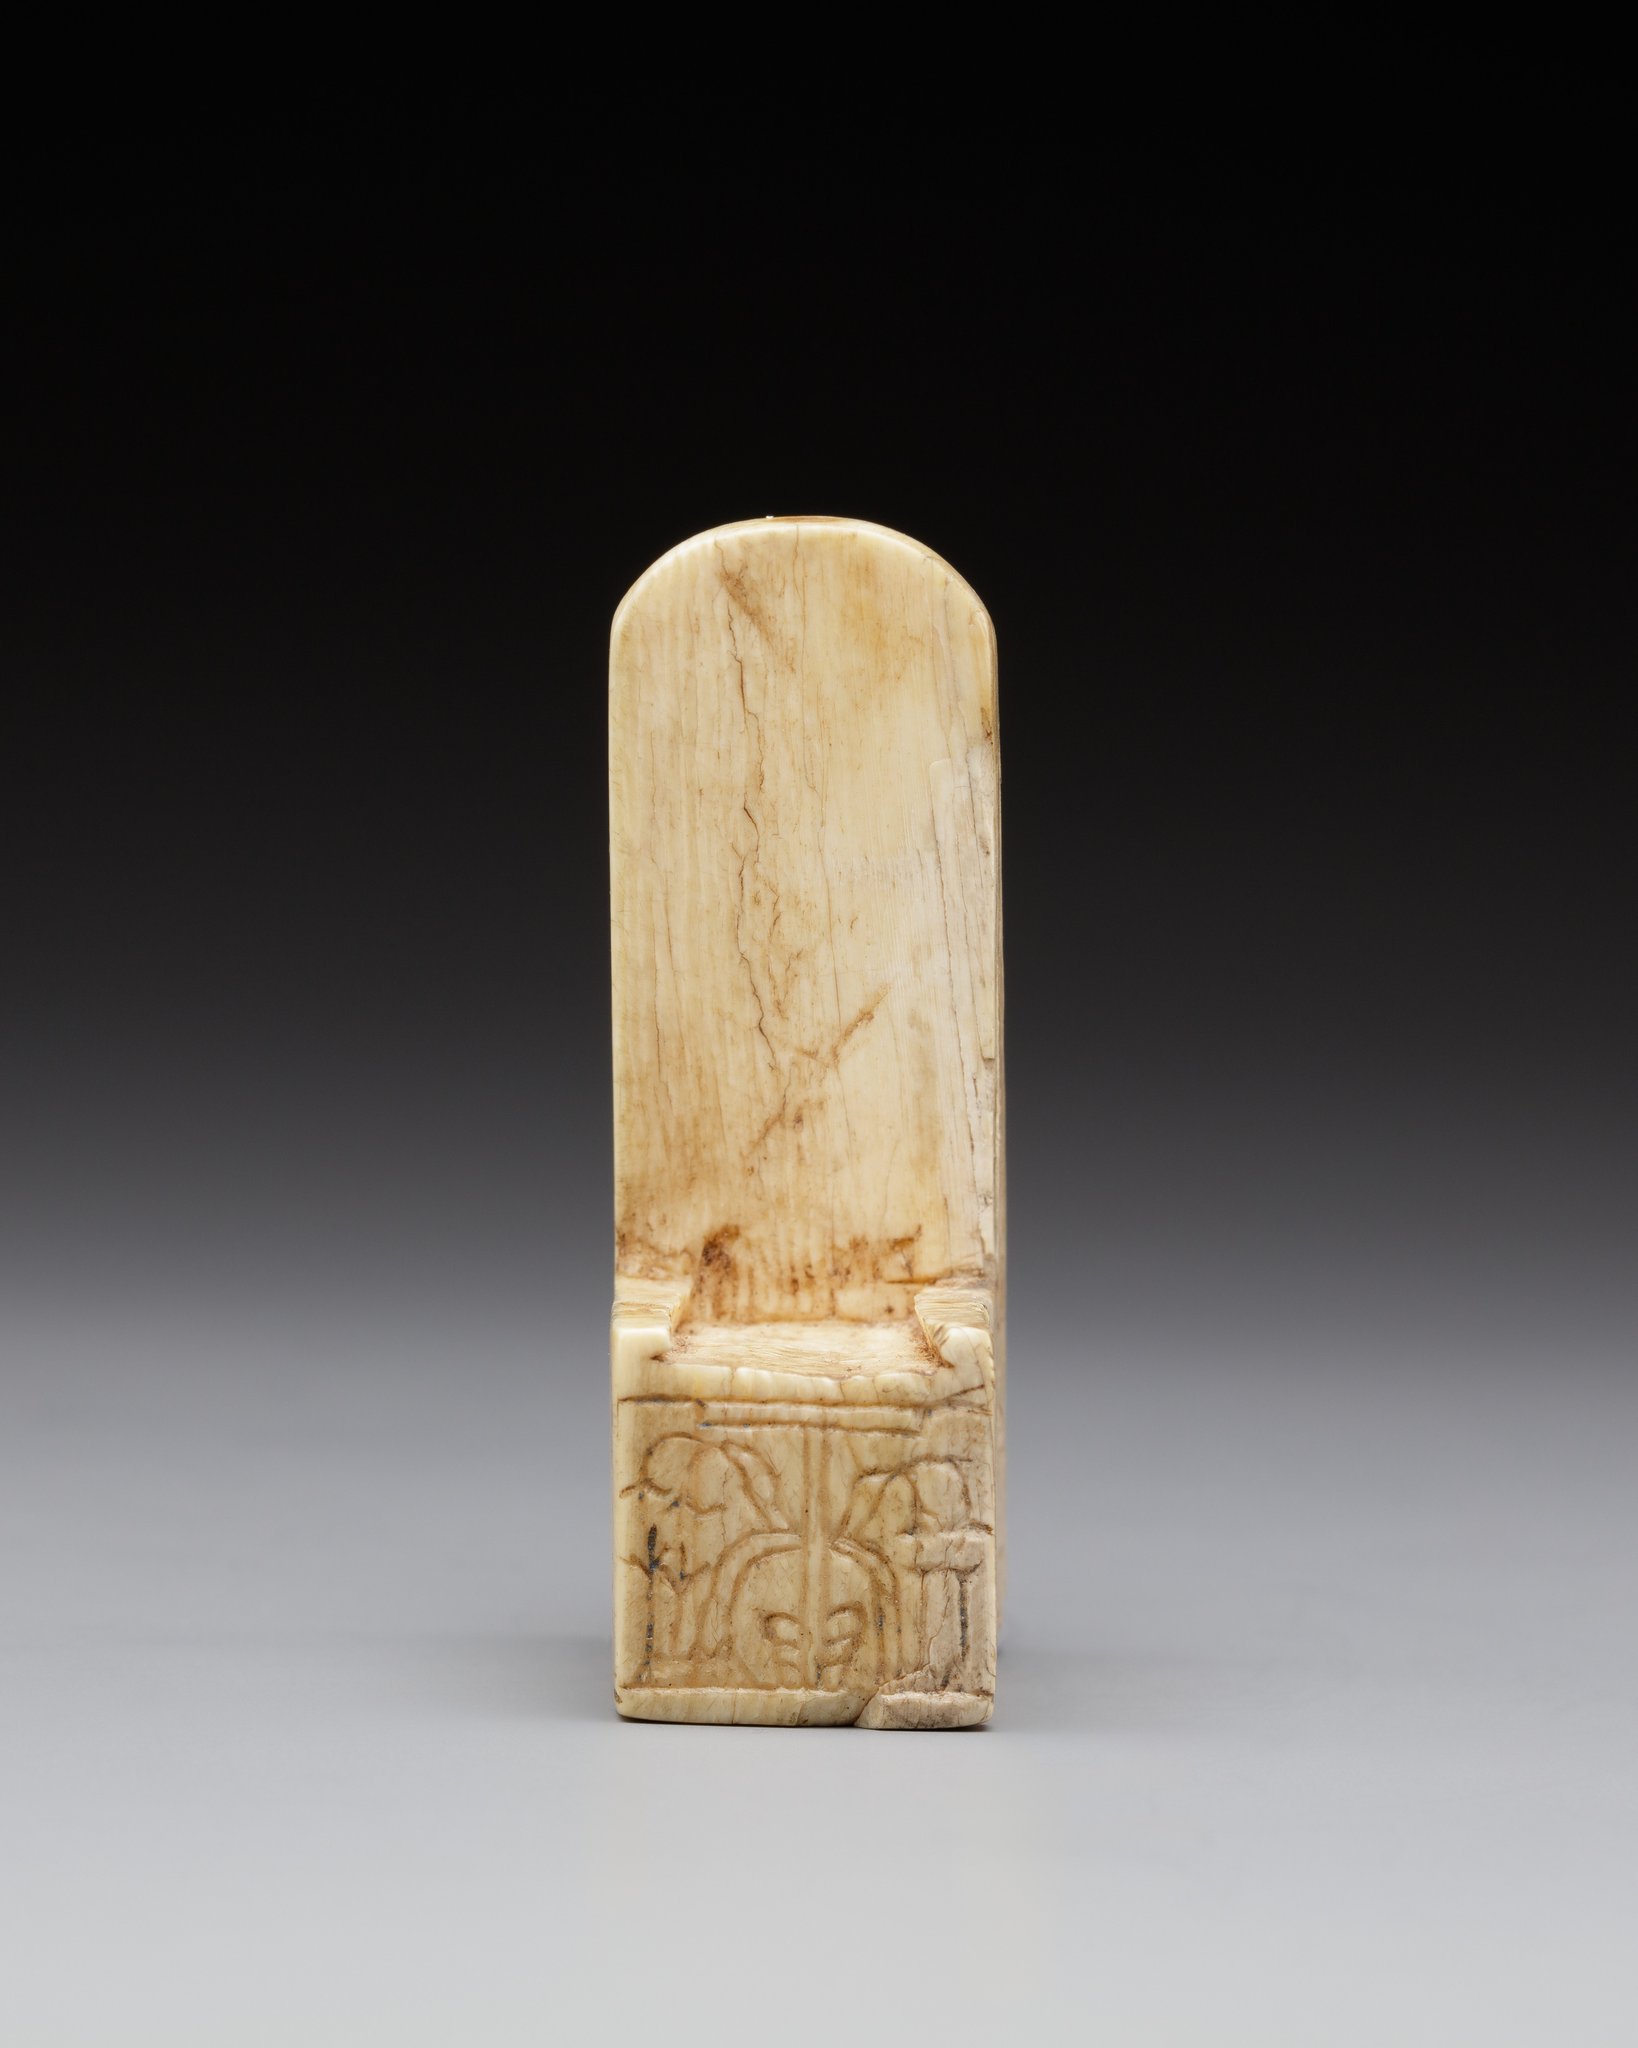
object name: statue pedestal, miniature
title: Pedestal for a Miniature Statue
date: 1353-1336 BCE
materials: ivory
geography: middle egypt